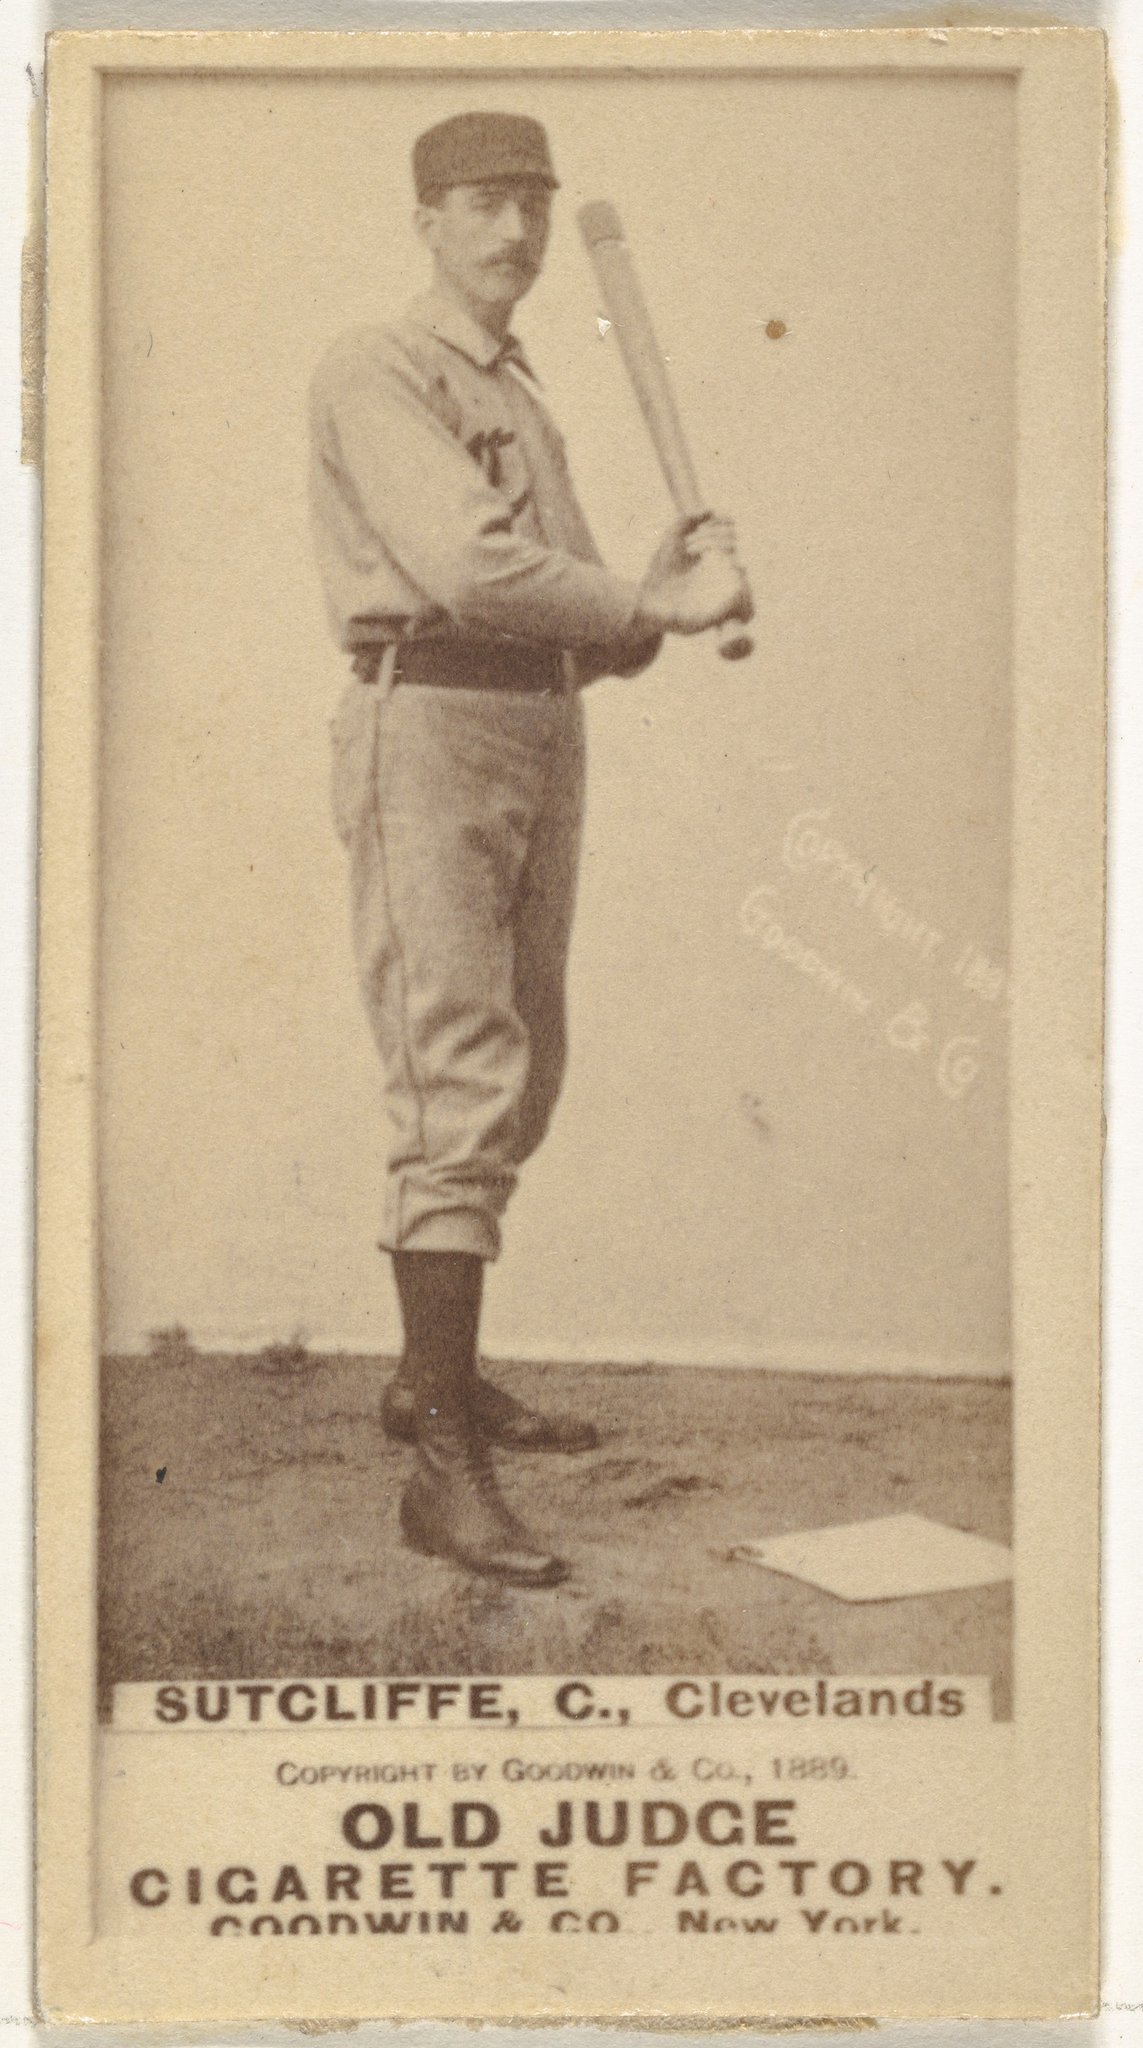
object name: baseball card, photograph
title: Elmer Ellsworth "Sy" Sutcliffe, Catcher, Cleveland, from the Old Judge series (N172) for Old Judge Cigarettes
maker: goodwin & company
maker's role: publisher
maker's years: 1850-1950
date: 1889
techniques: albumen silver print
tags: men,portraits,baseball,athletes